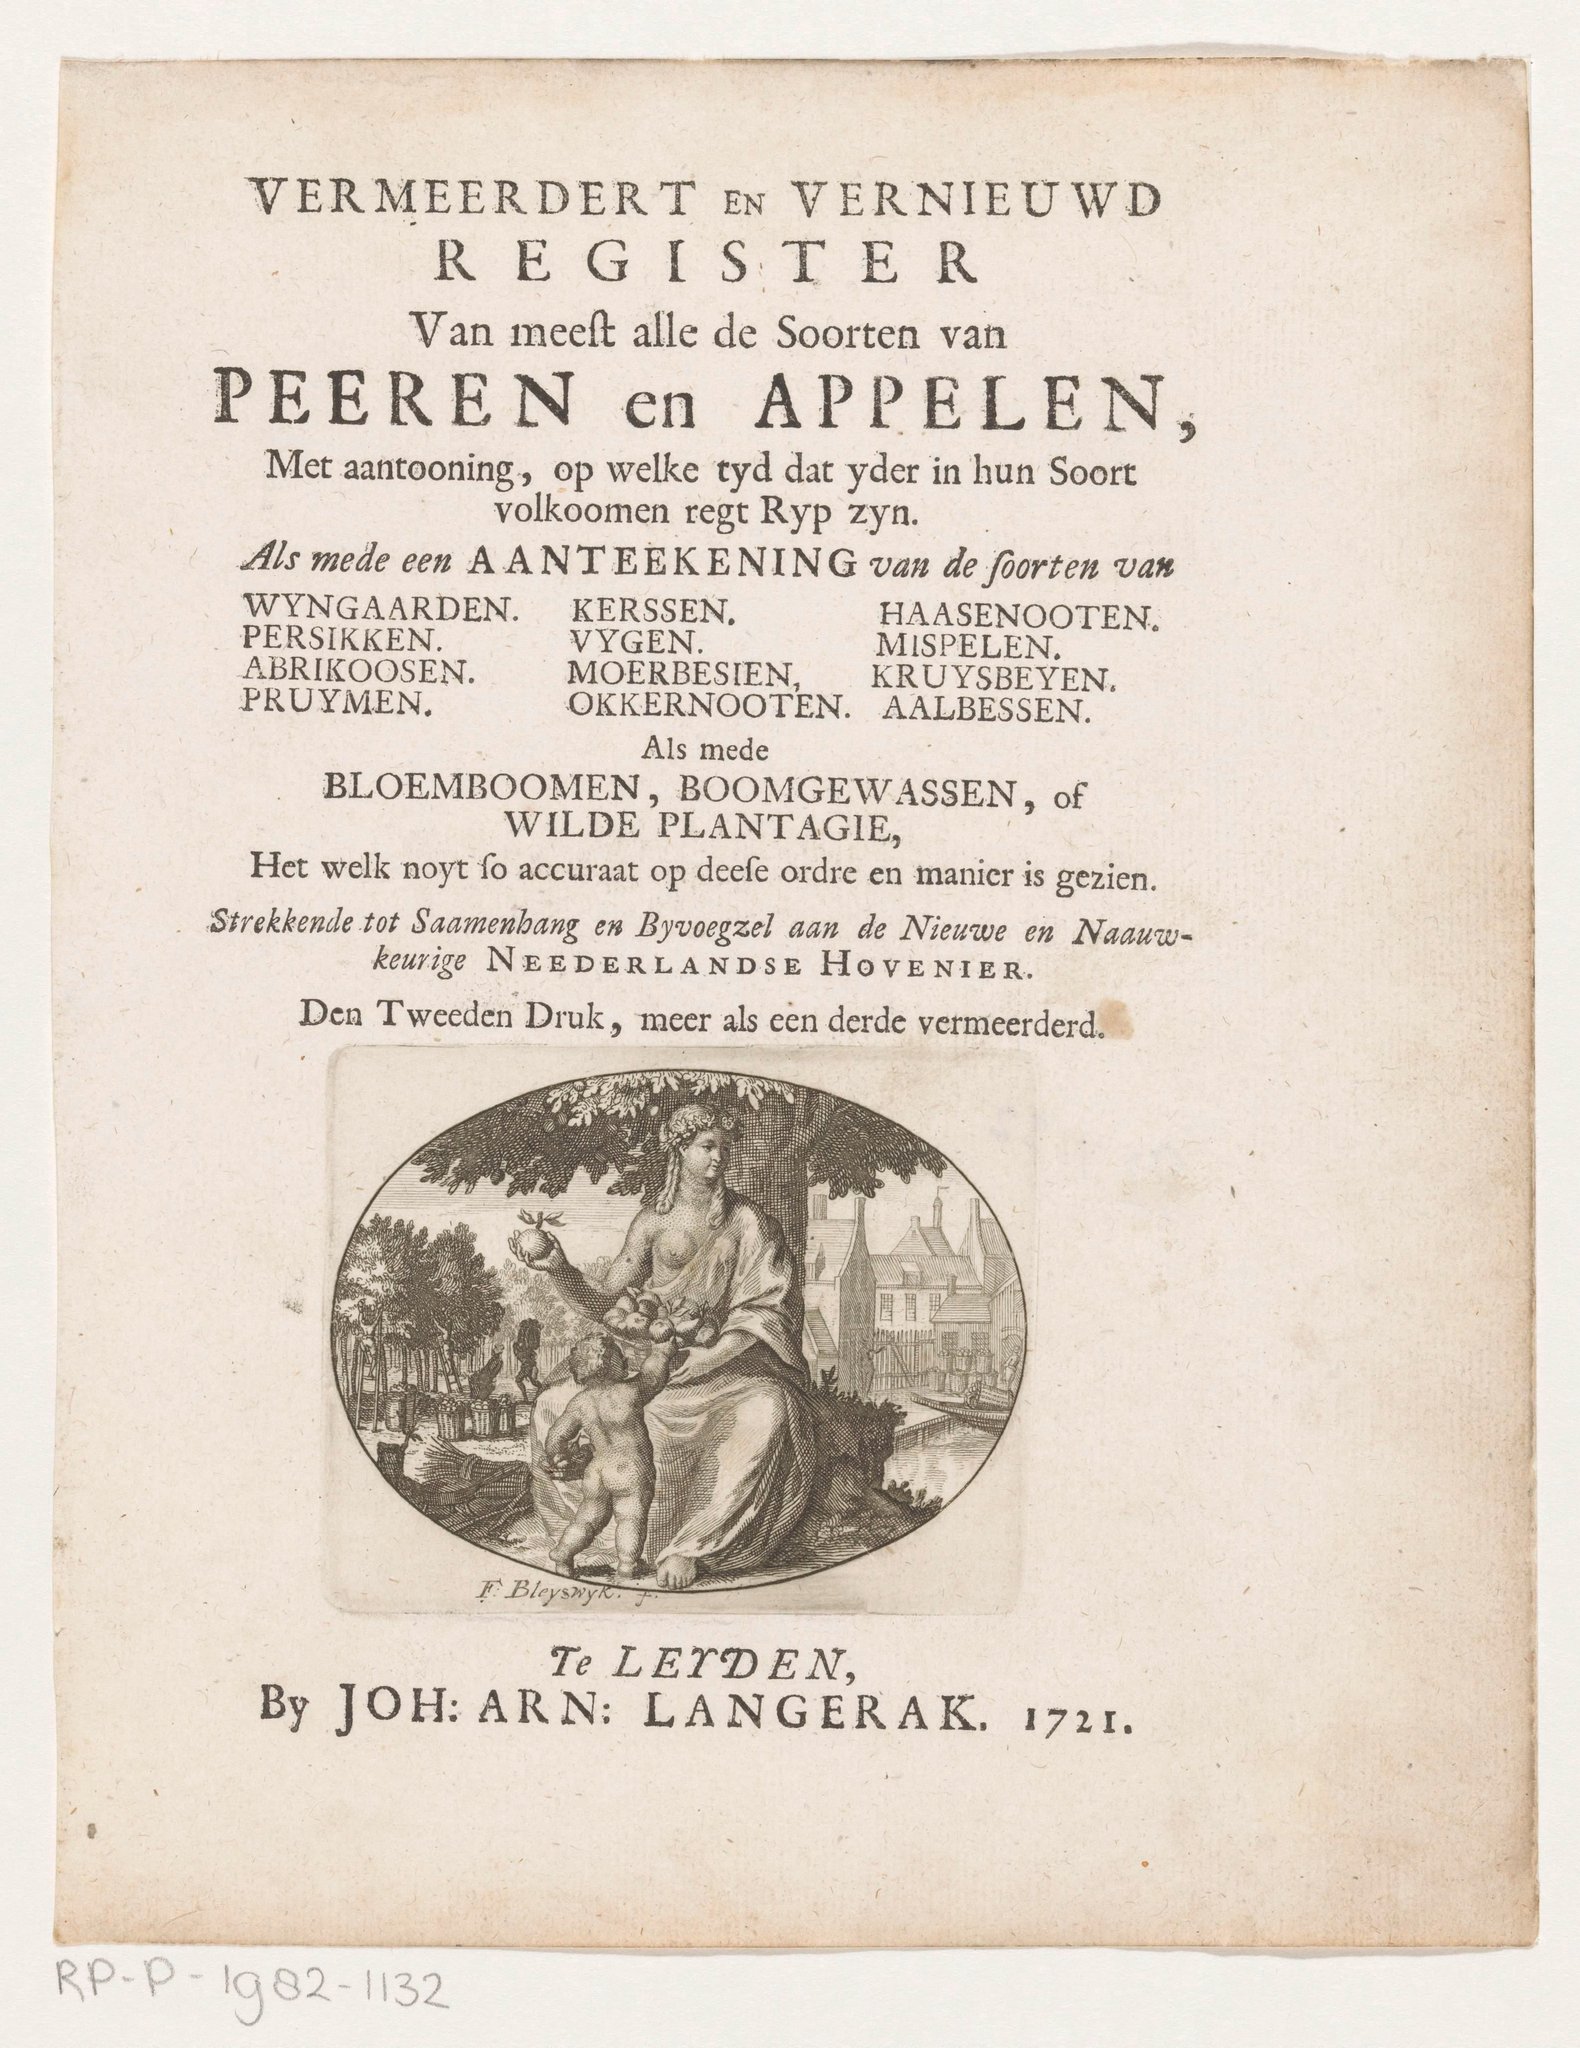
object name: print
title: Titelpagina voor: S.n., Vermeerdert en vernieuwd register Van meest alle de Soorten van peeren en appelen, 1721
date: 1721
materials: paper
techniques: engraving, letterpress printing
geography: leiden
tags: fruit harvest, fruits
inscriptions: collector's mark: Lugt 2228, collector's mark: Lugt 2760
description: Een vrouw met een appel en een gevulde fruitmand in haar handen zit onder een fruitboom. Een putto pakt fruit uit de mand en vult hiermee een eigen mand. In de achtergrond telen figuren fruit. Rechts een gezicht op een stad aan het water.